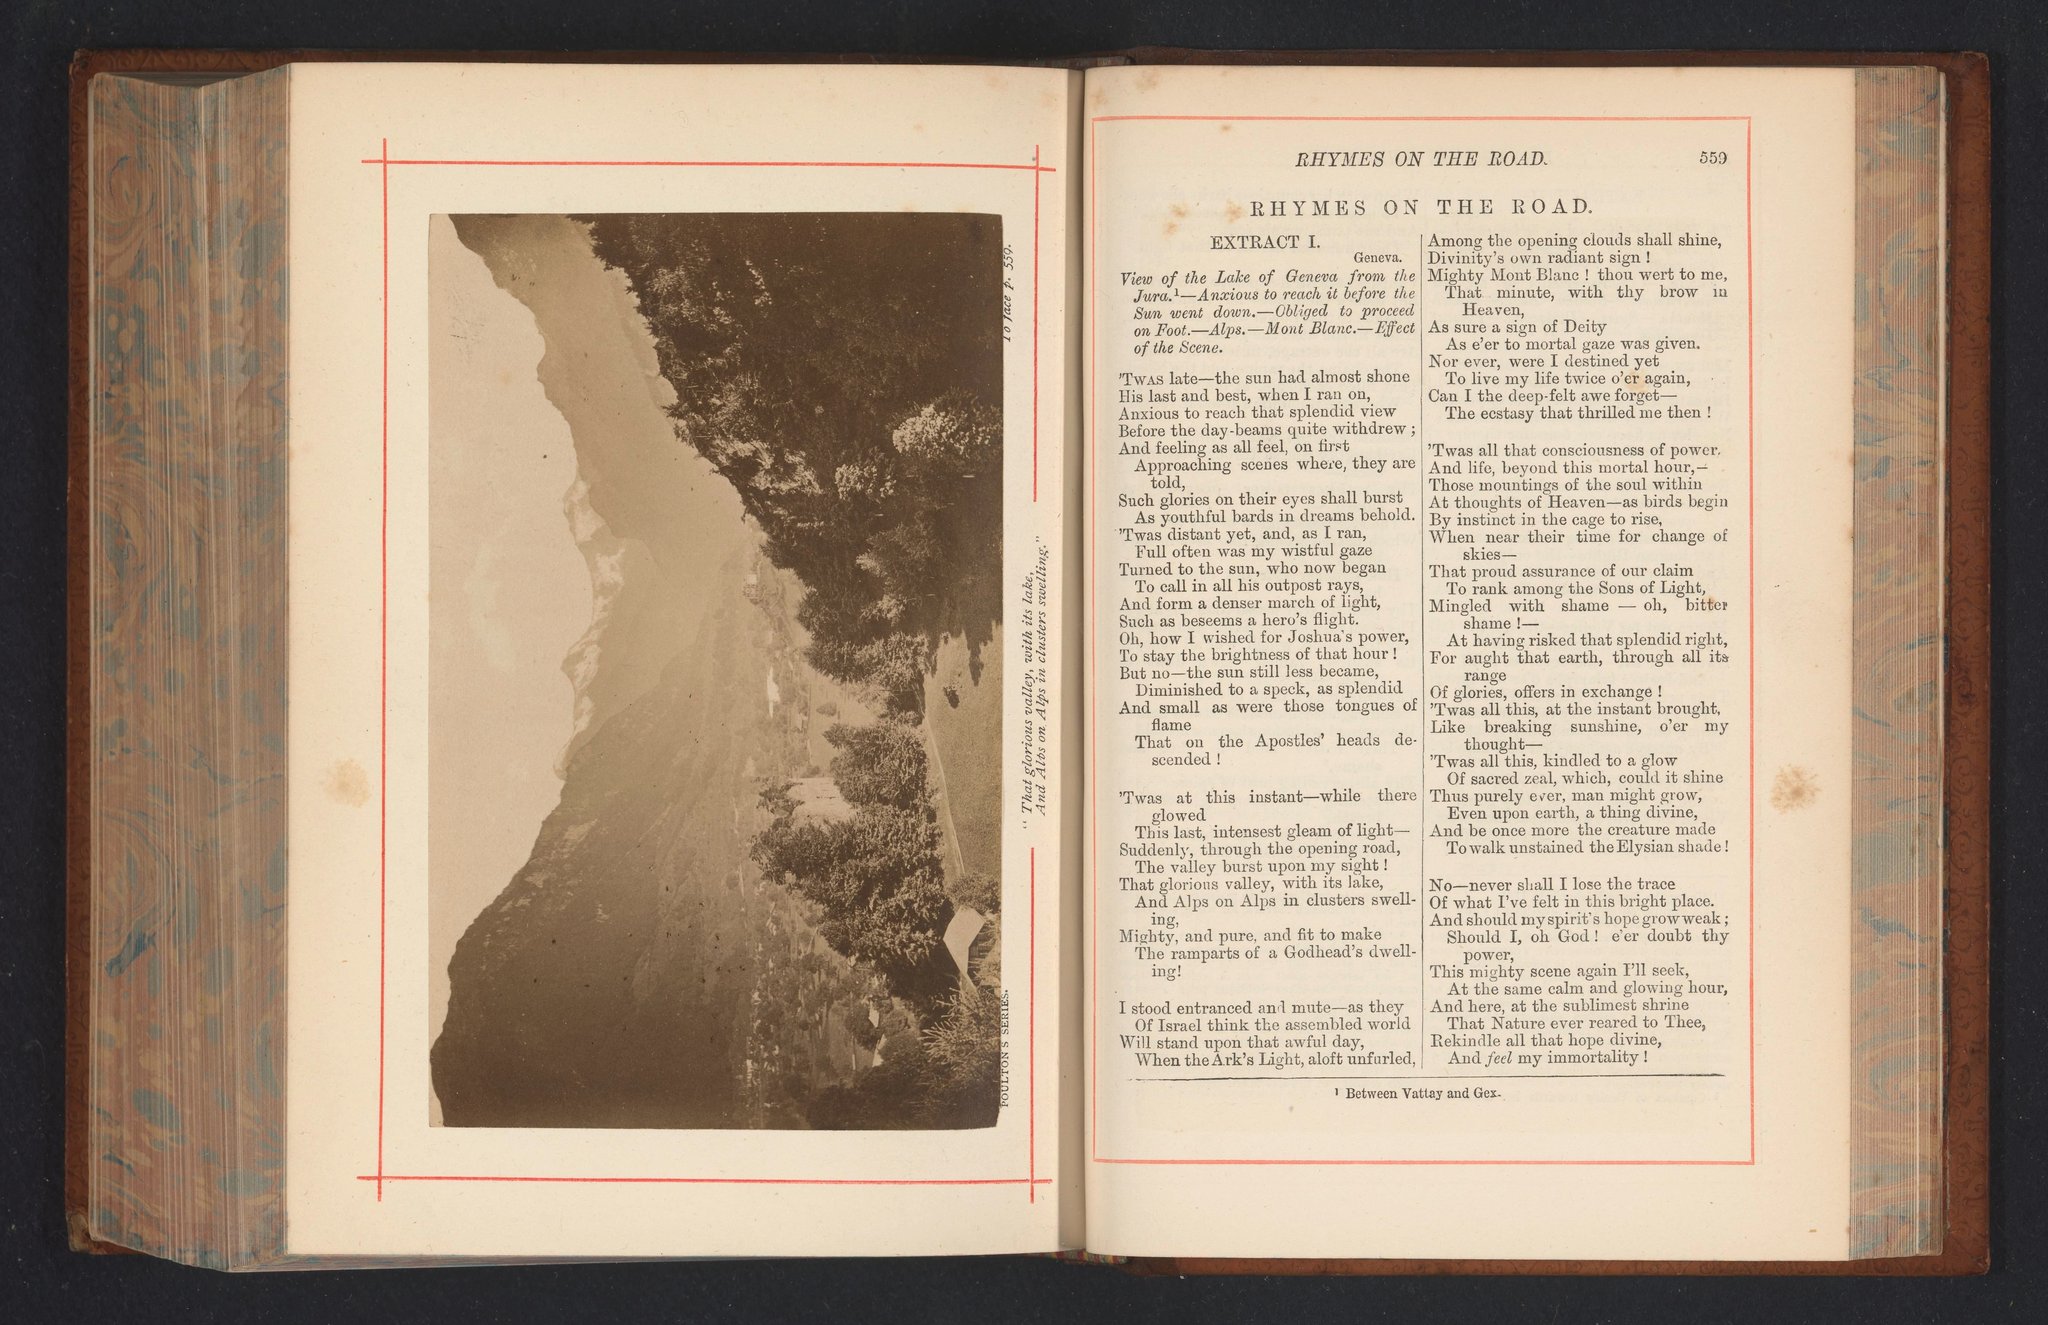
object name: page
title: Gezicht op een vallei te Ierland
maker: Anonymous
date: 1882-1892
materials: photographic support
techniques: albumen print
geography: ireland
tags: dale, valley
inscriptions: inscription: ‘"That glorious (...) clusters swelling."’